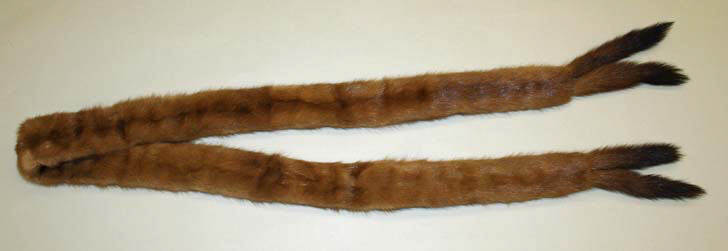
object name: accessory set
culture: american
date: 1880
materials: fur, silk